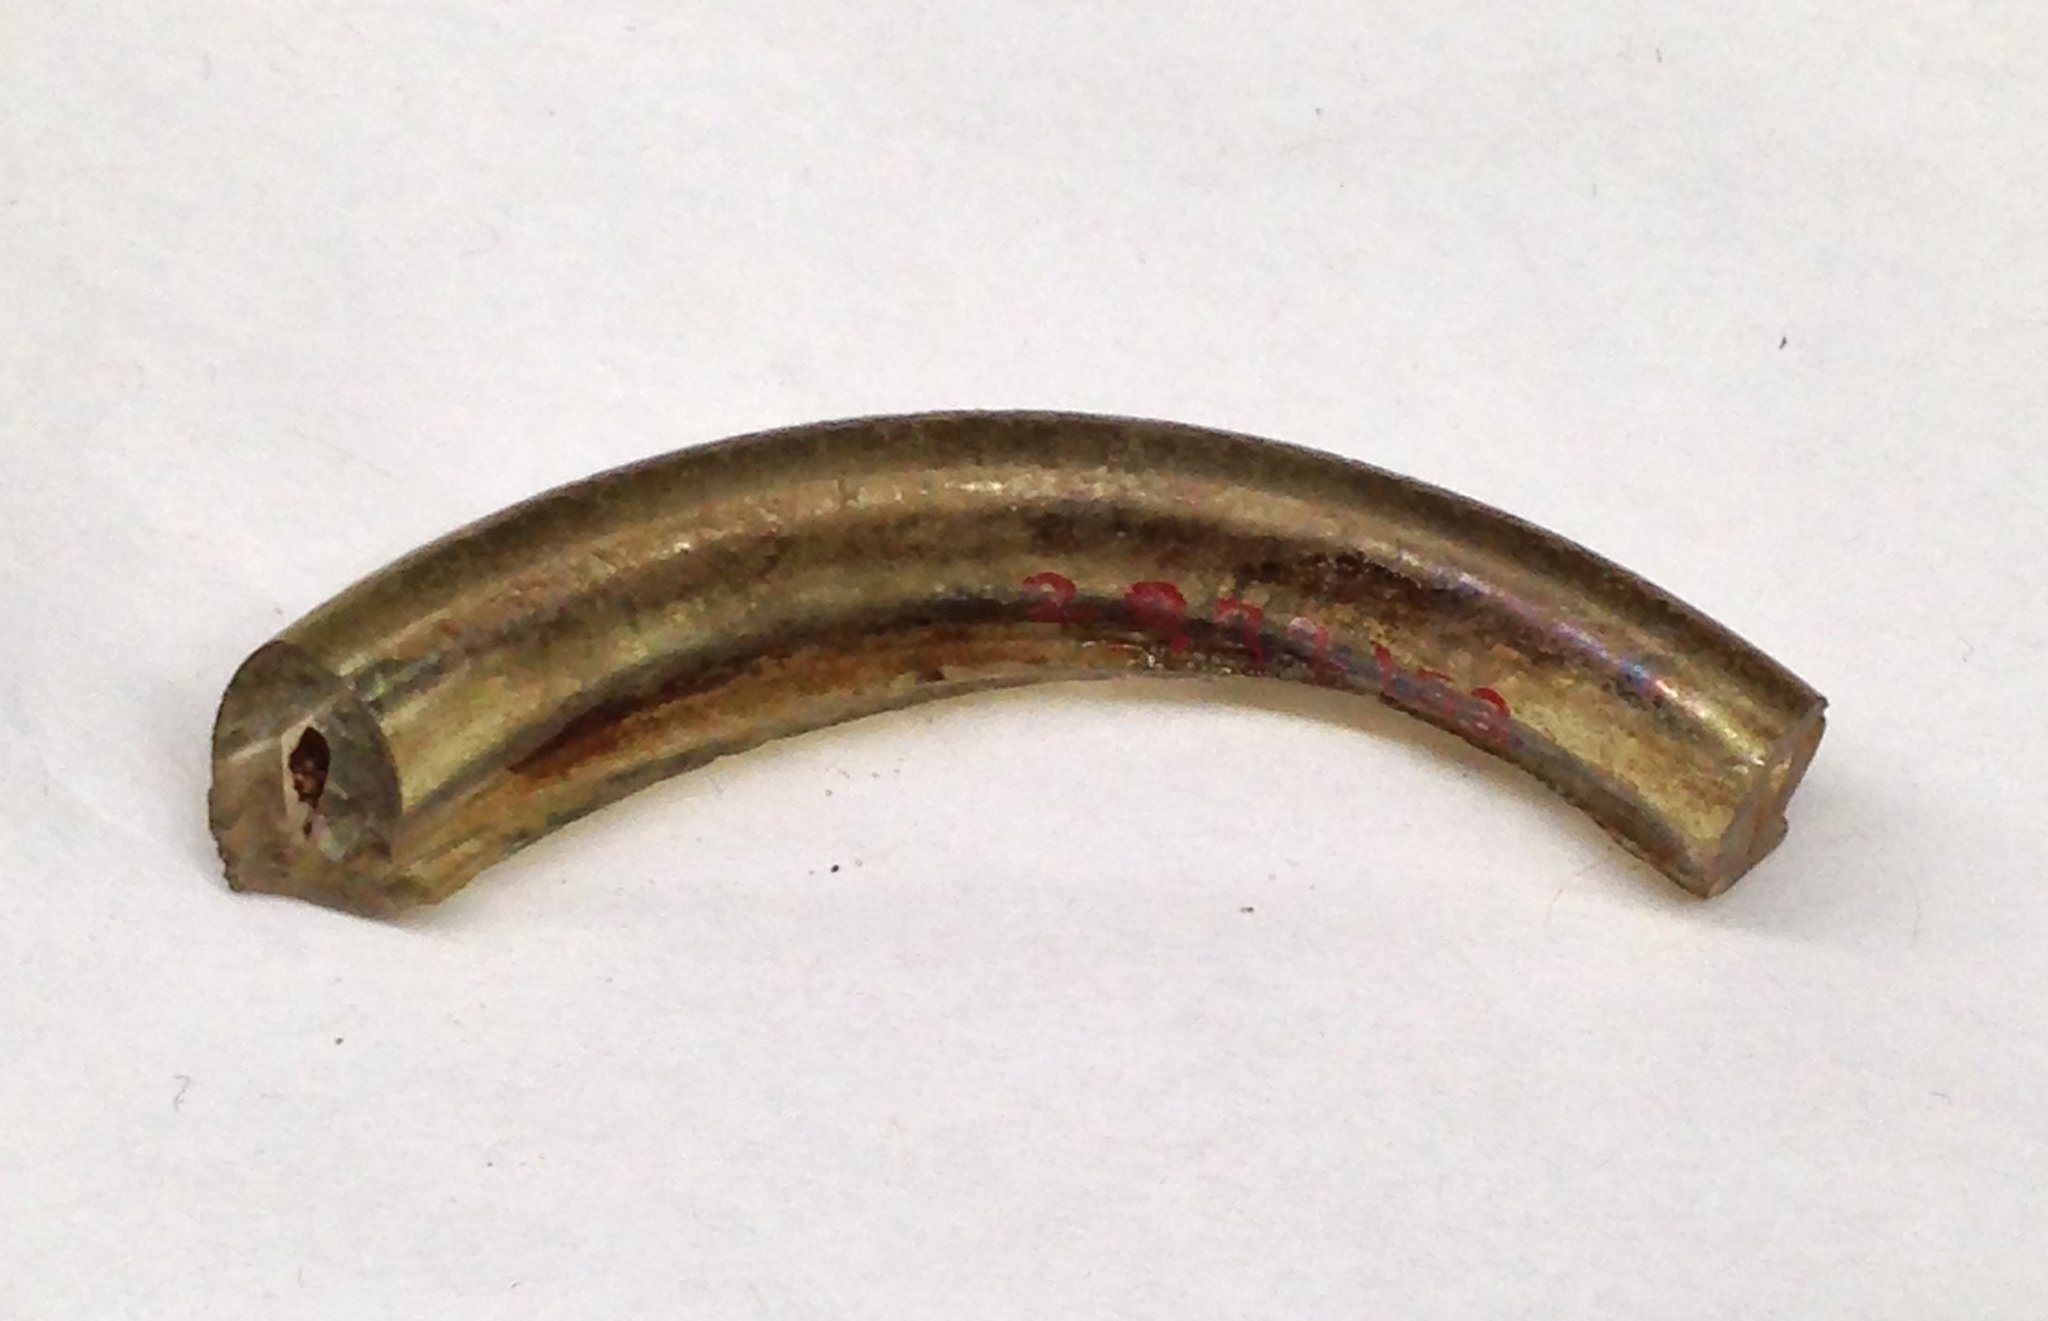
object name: fragment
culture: european or middle eastern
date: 1150-1250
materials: ceramic, glass